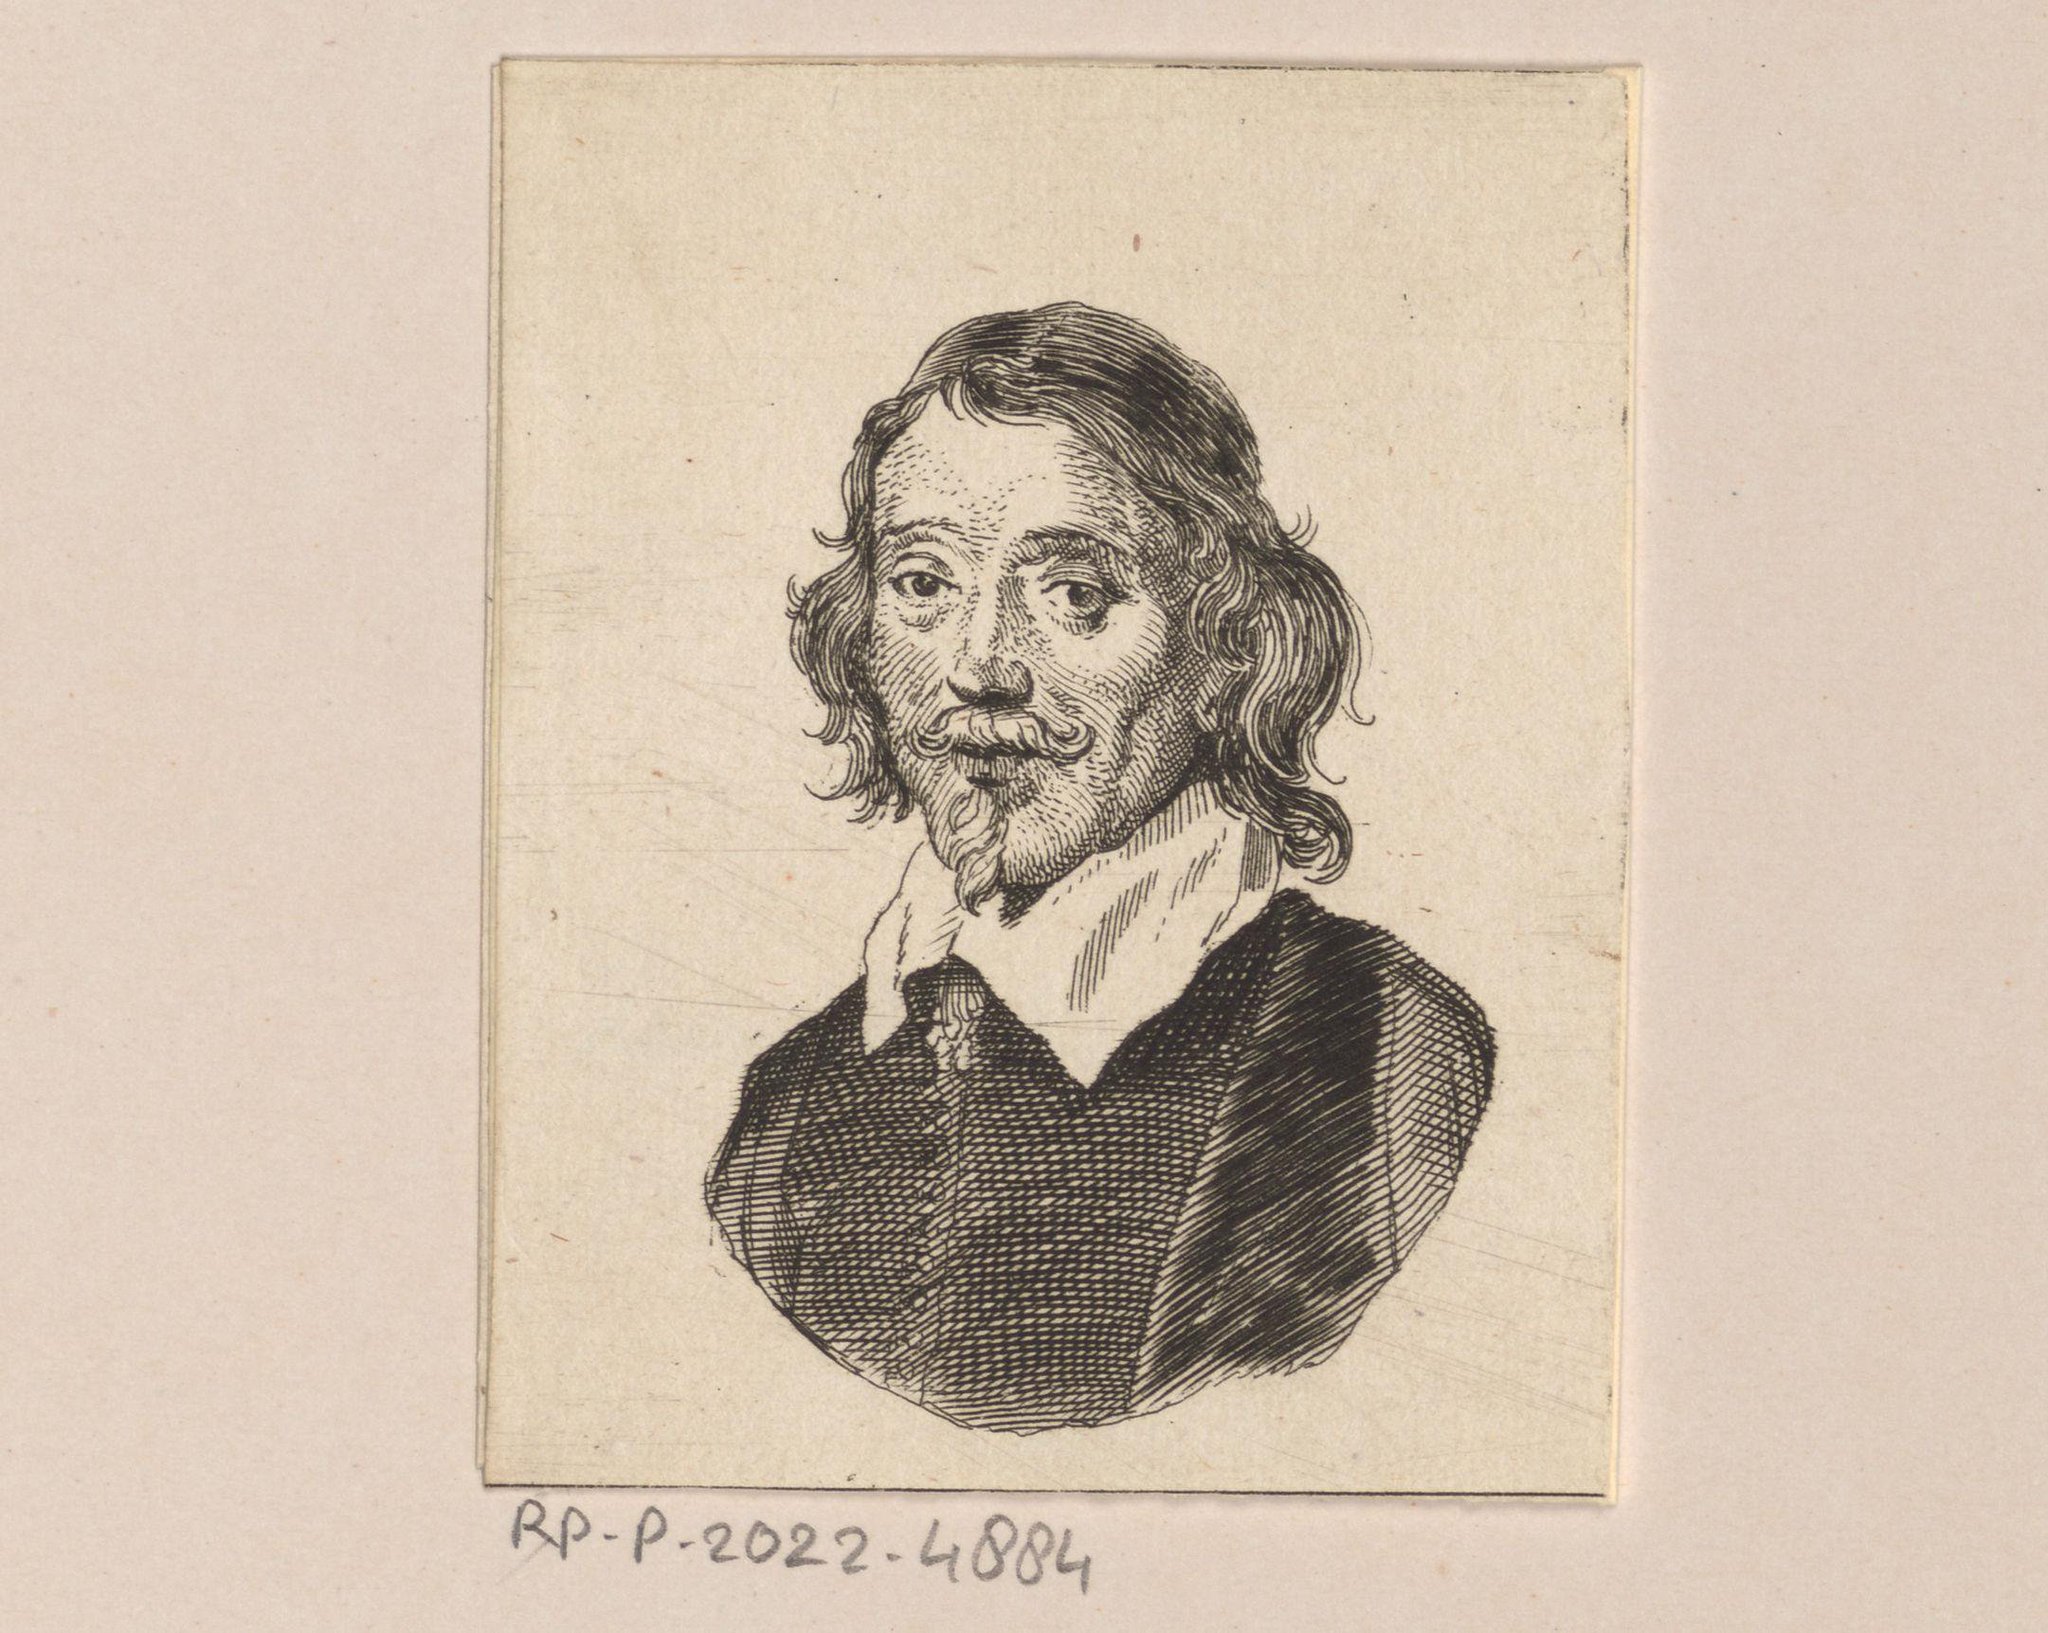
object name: print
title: Portret van Adolph Vorstius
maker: Anonymous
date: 1700-1799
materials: paper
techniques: etching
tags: delft, scholar, philosopher, historical persons